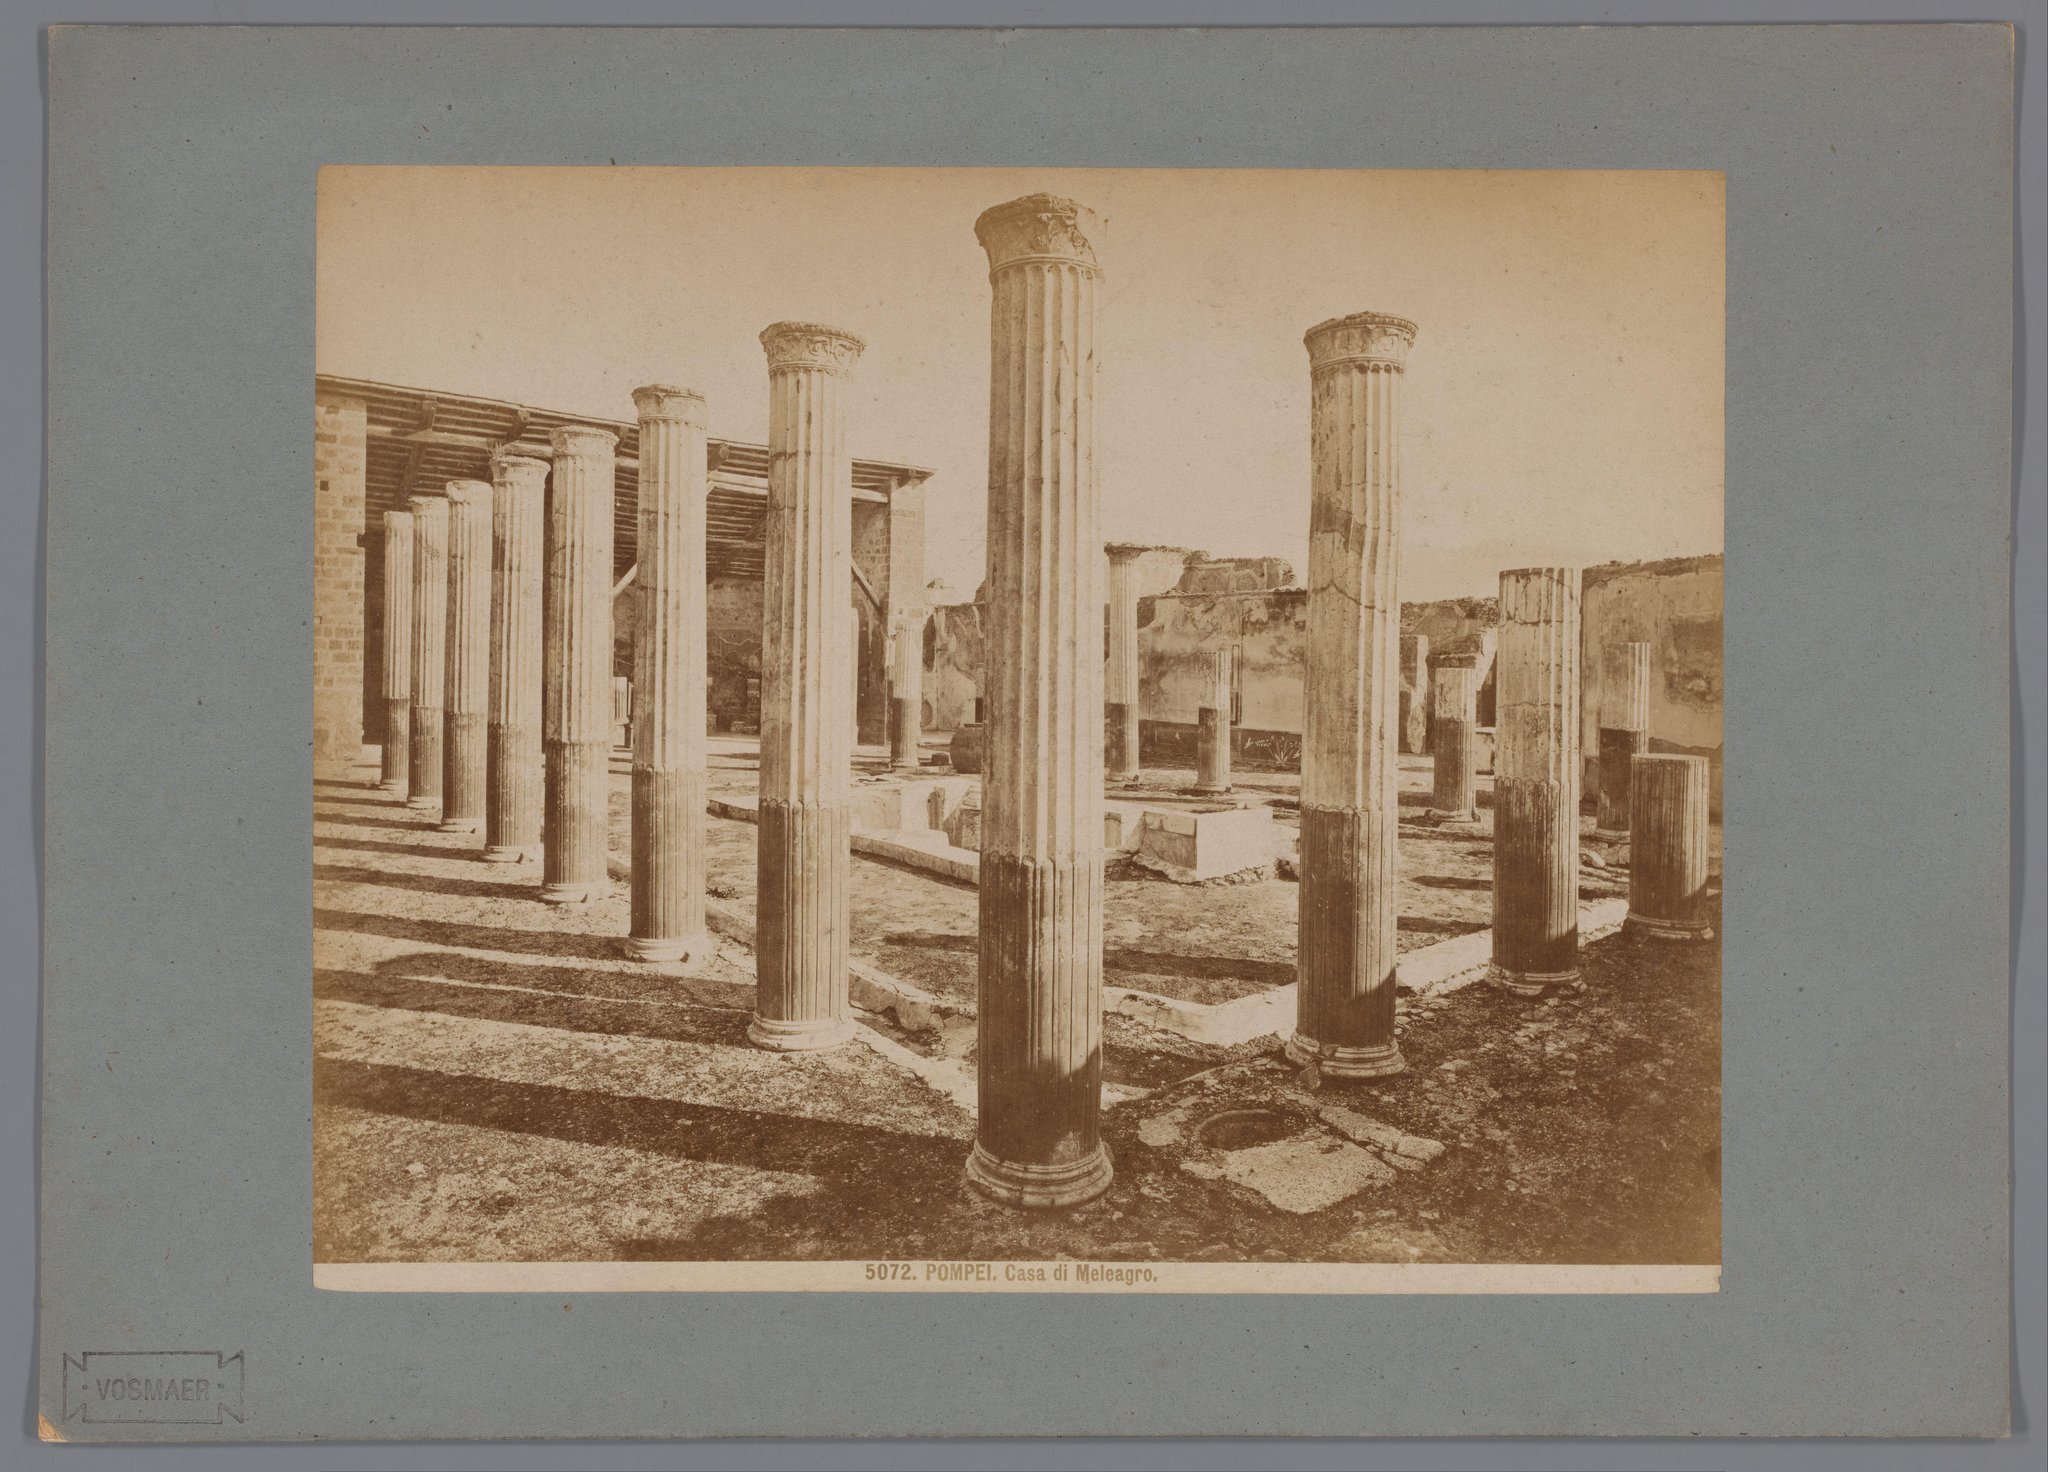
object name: photograph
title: Casa di Meleagro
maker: giacomo brogi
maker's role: fotograaf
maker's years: 1822-1881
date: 1864-1881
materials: cardboard, paper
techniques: albumen print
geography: pompeii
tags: urban housing, ruin of a building ~ architecture, landscape with ruins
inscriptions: number: ‘5072.’, collector's mark: ‘VOSMAER’